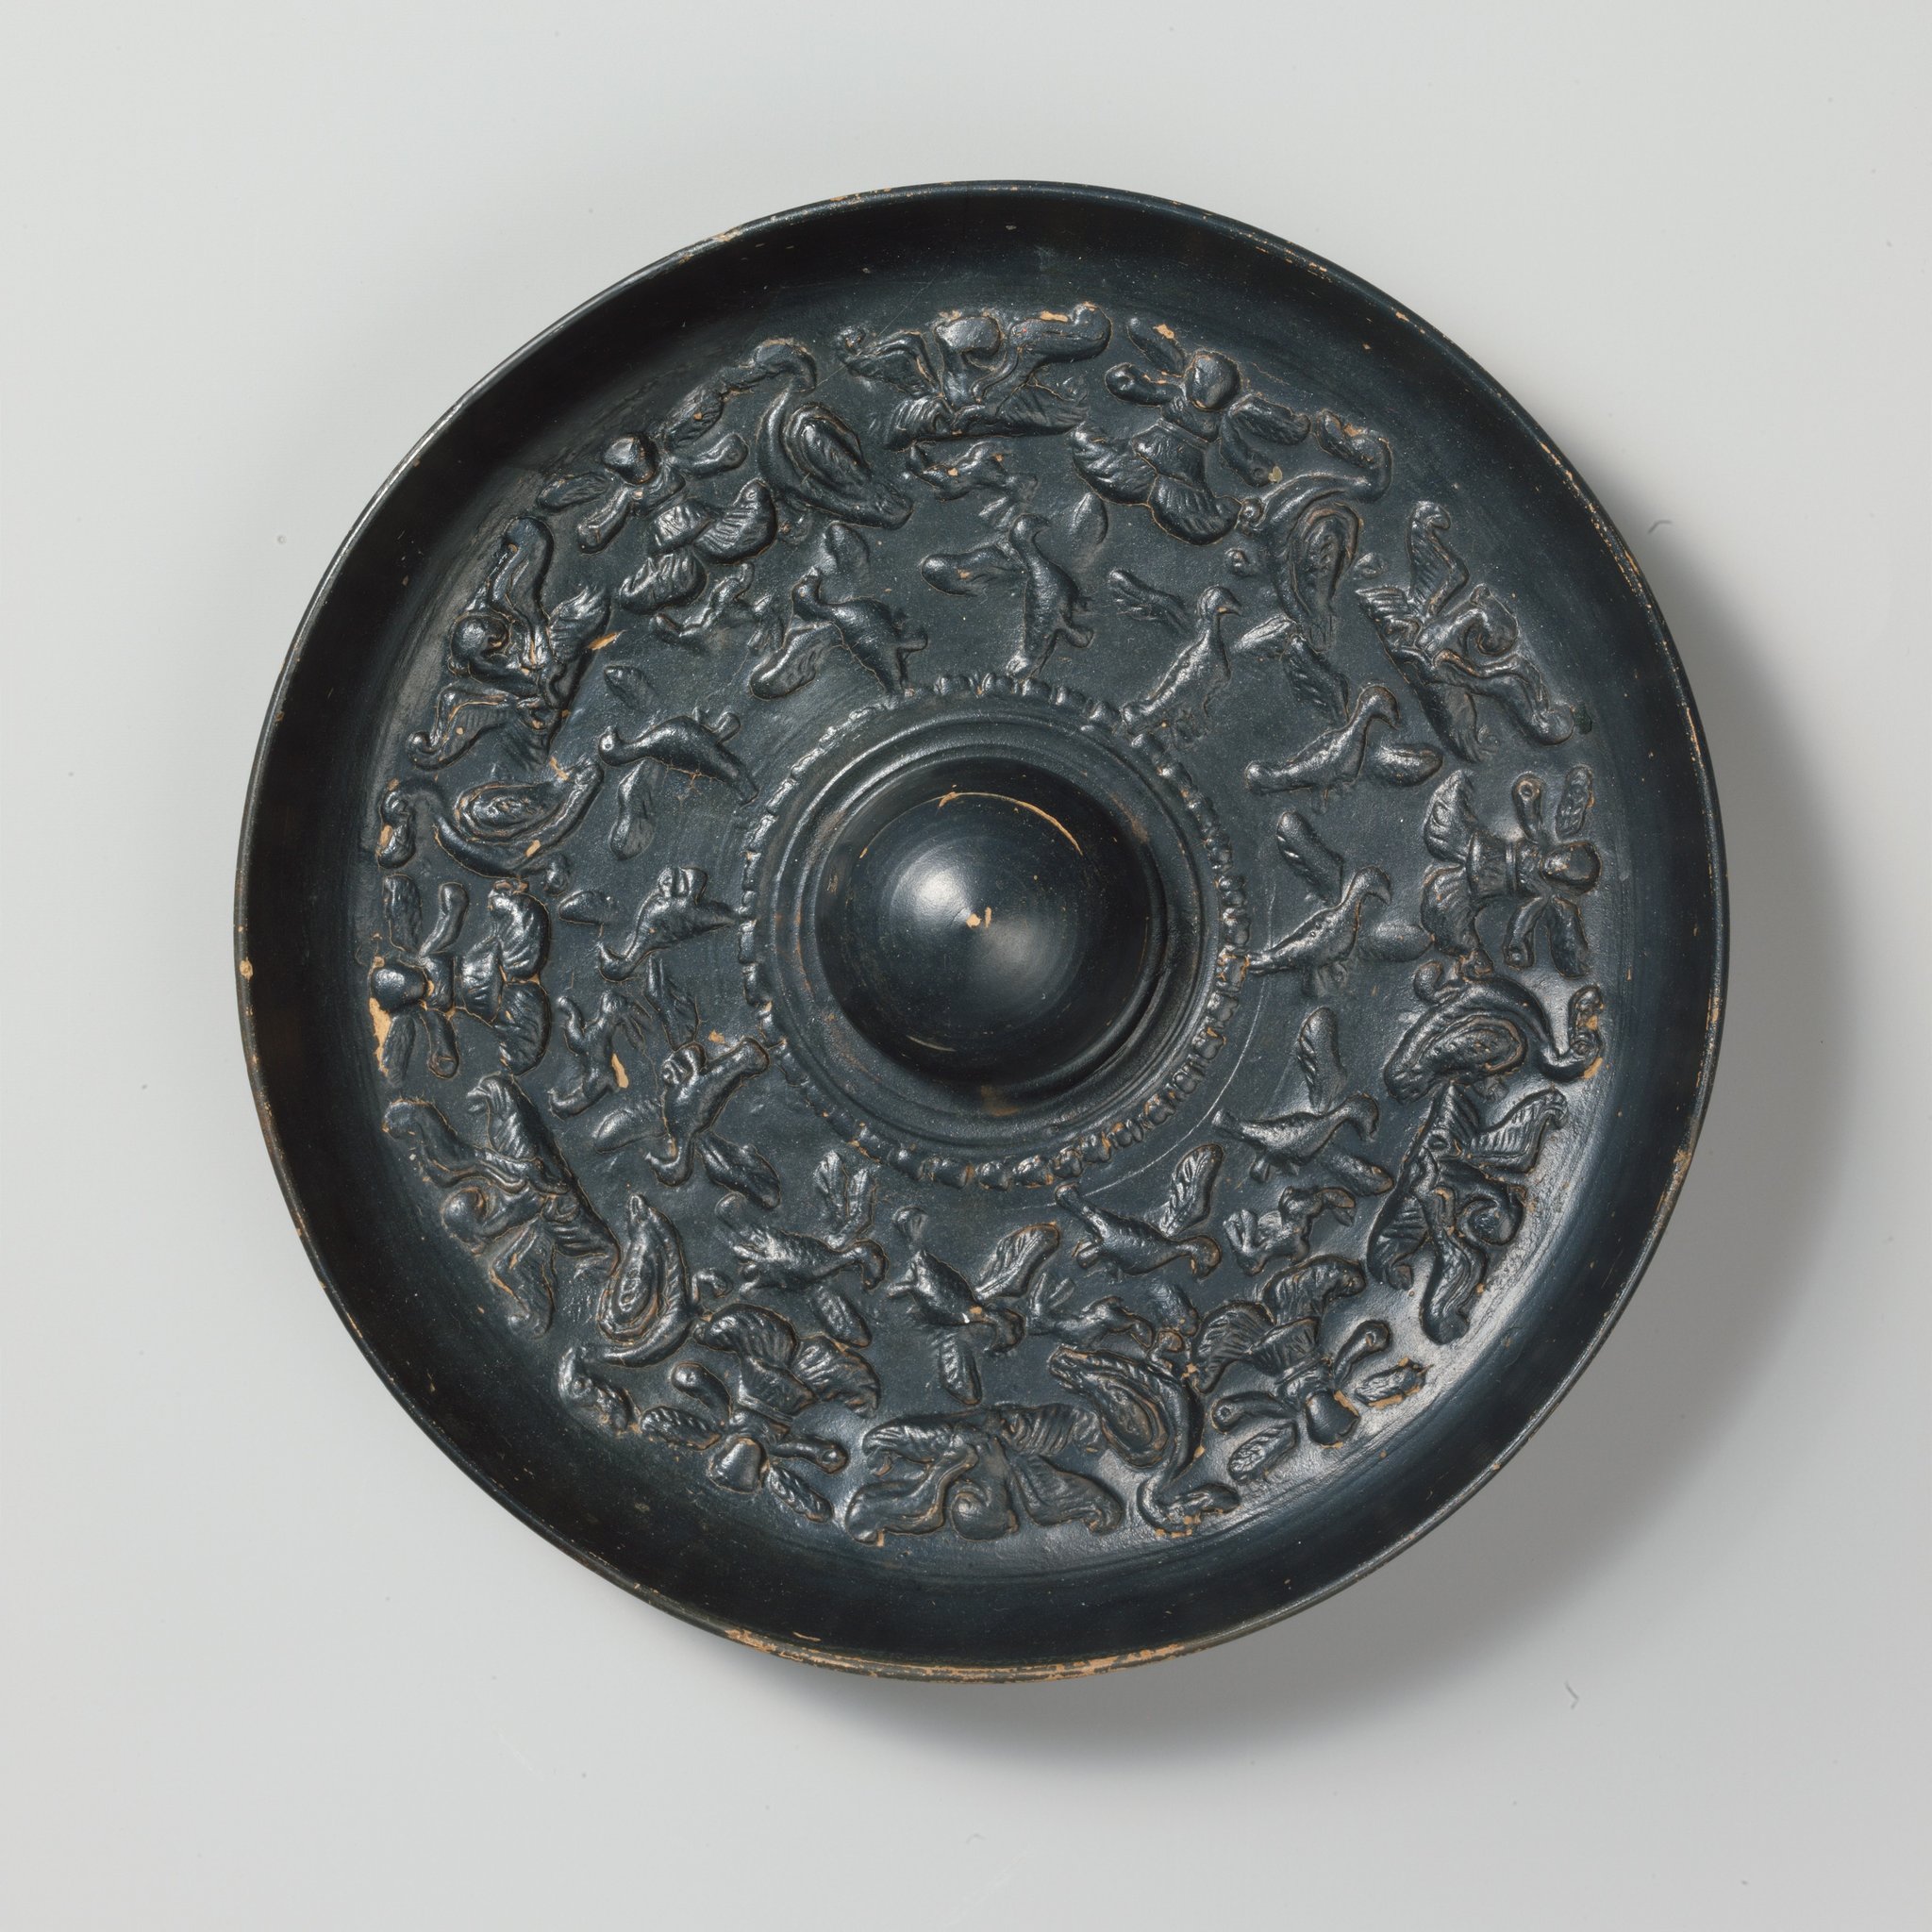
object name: phiale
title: Terracotta phiale (libation bowl)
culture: greek, calenian or campanian or south italian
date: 300-201 BCE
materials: terracotta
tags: birds